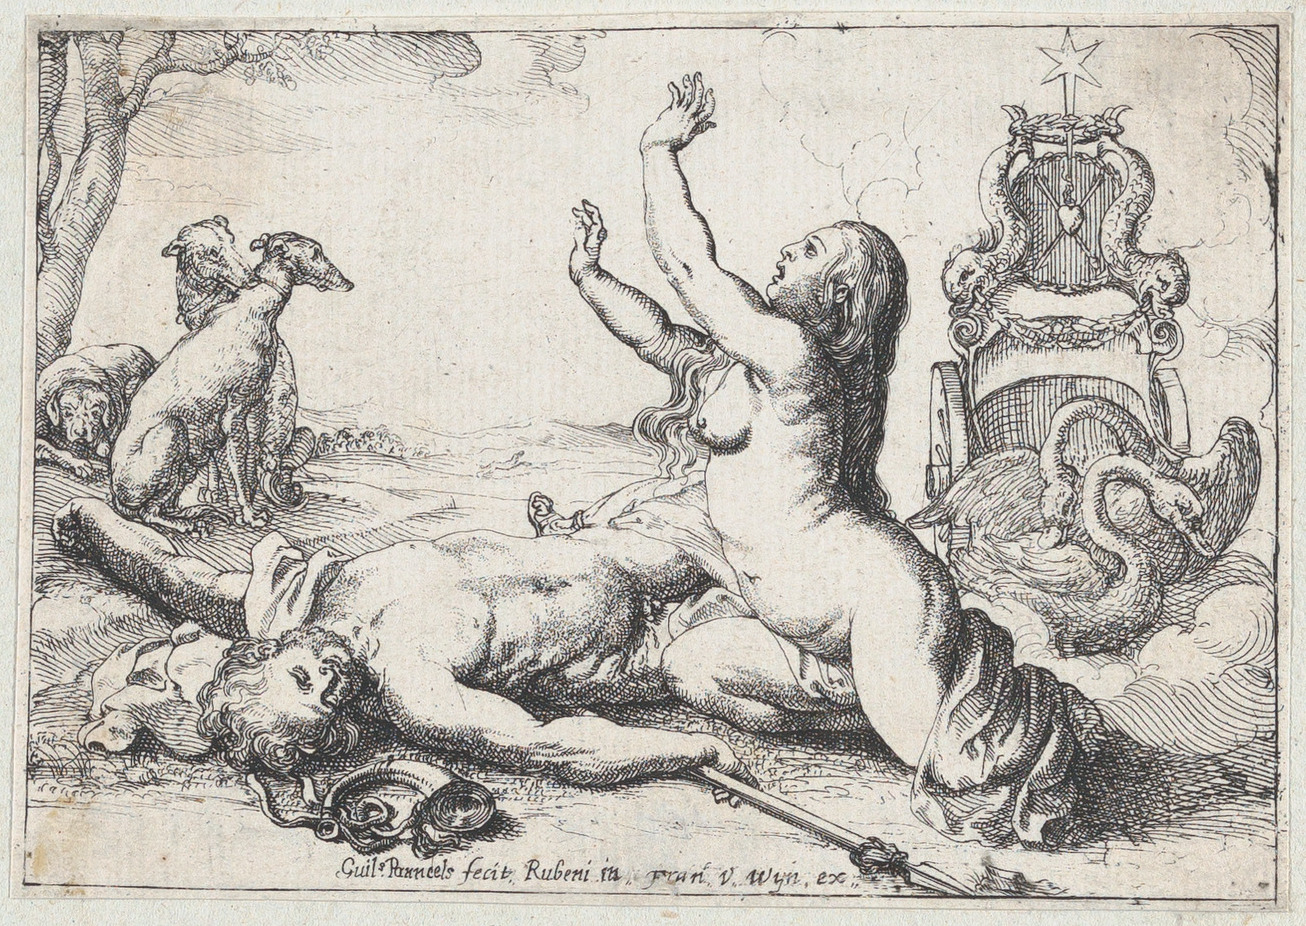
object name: print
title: Venus mourning Adonis, who lies on the ground at left with his dogs behind him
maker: willem panneels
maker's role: artist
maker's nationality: flemish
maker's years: 1600-1632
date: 1631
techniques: etching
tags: adonis,venus,swans,dogs